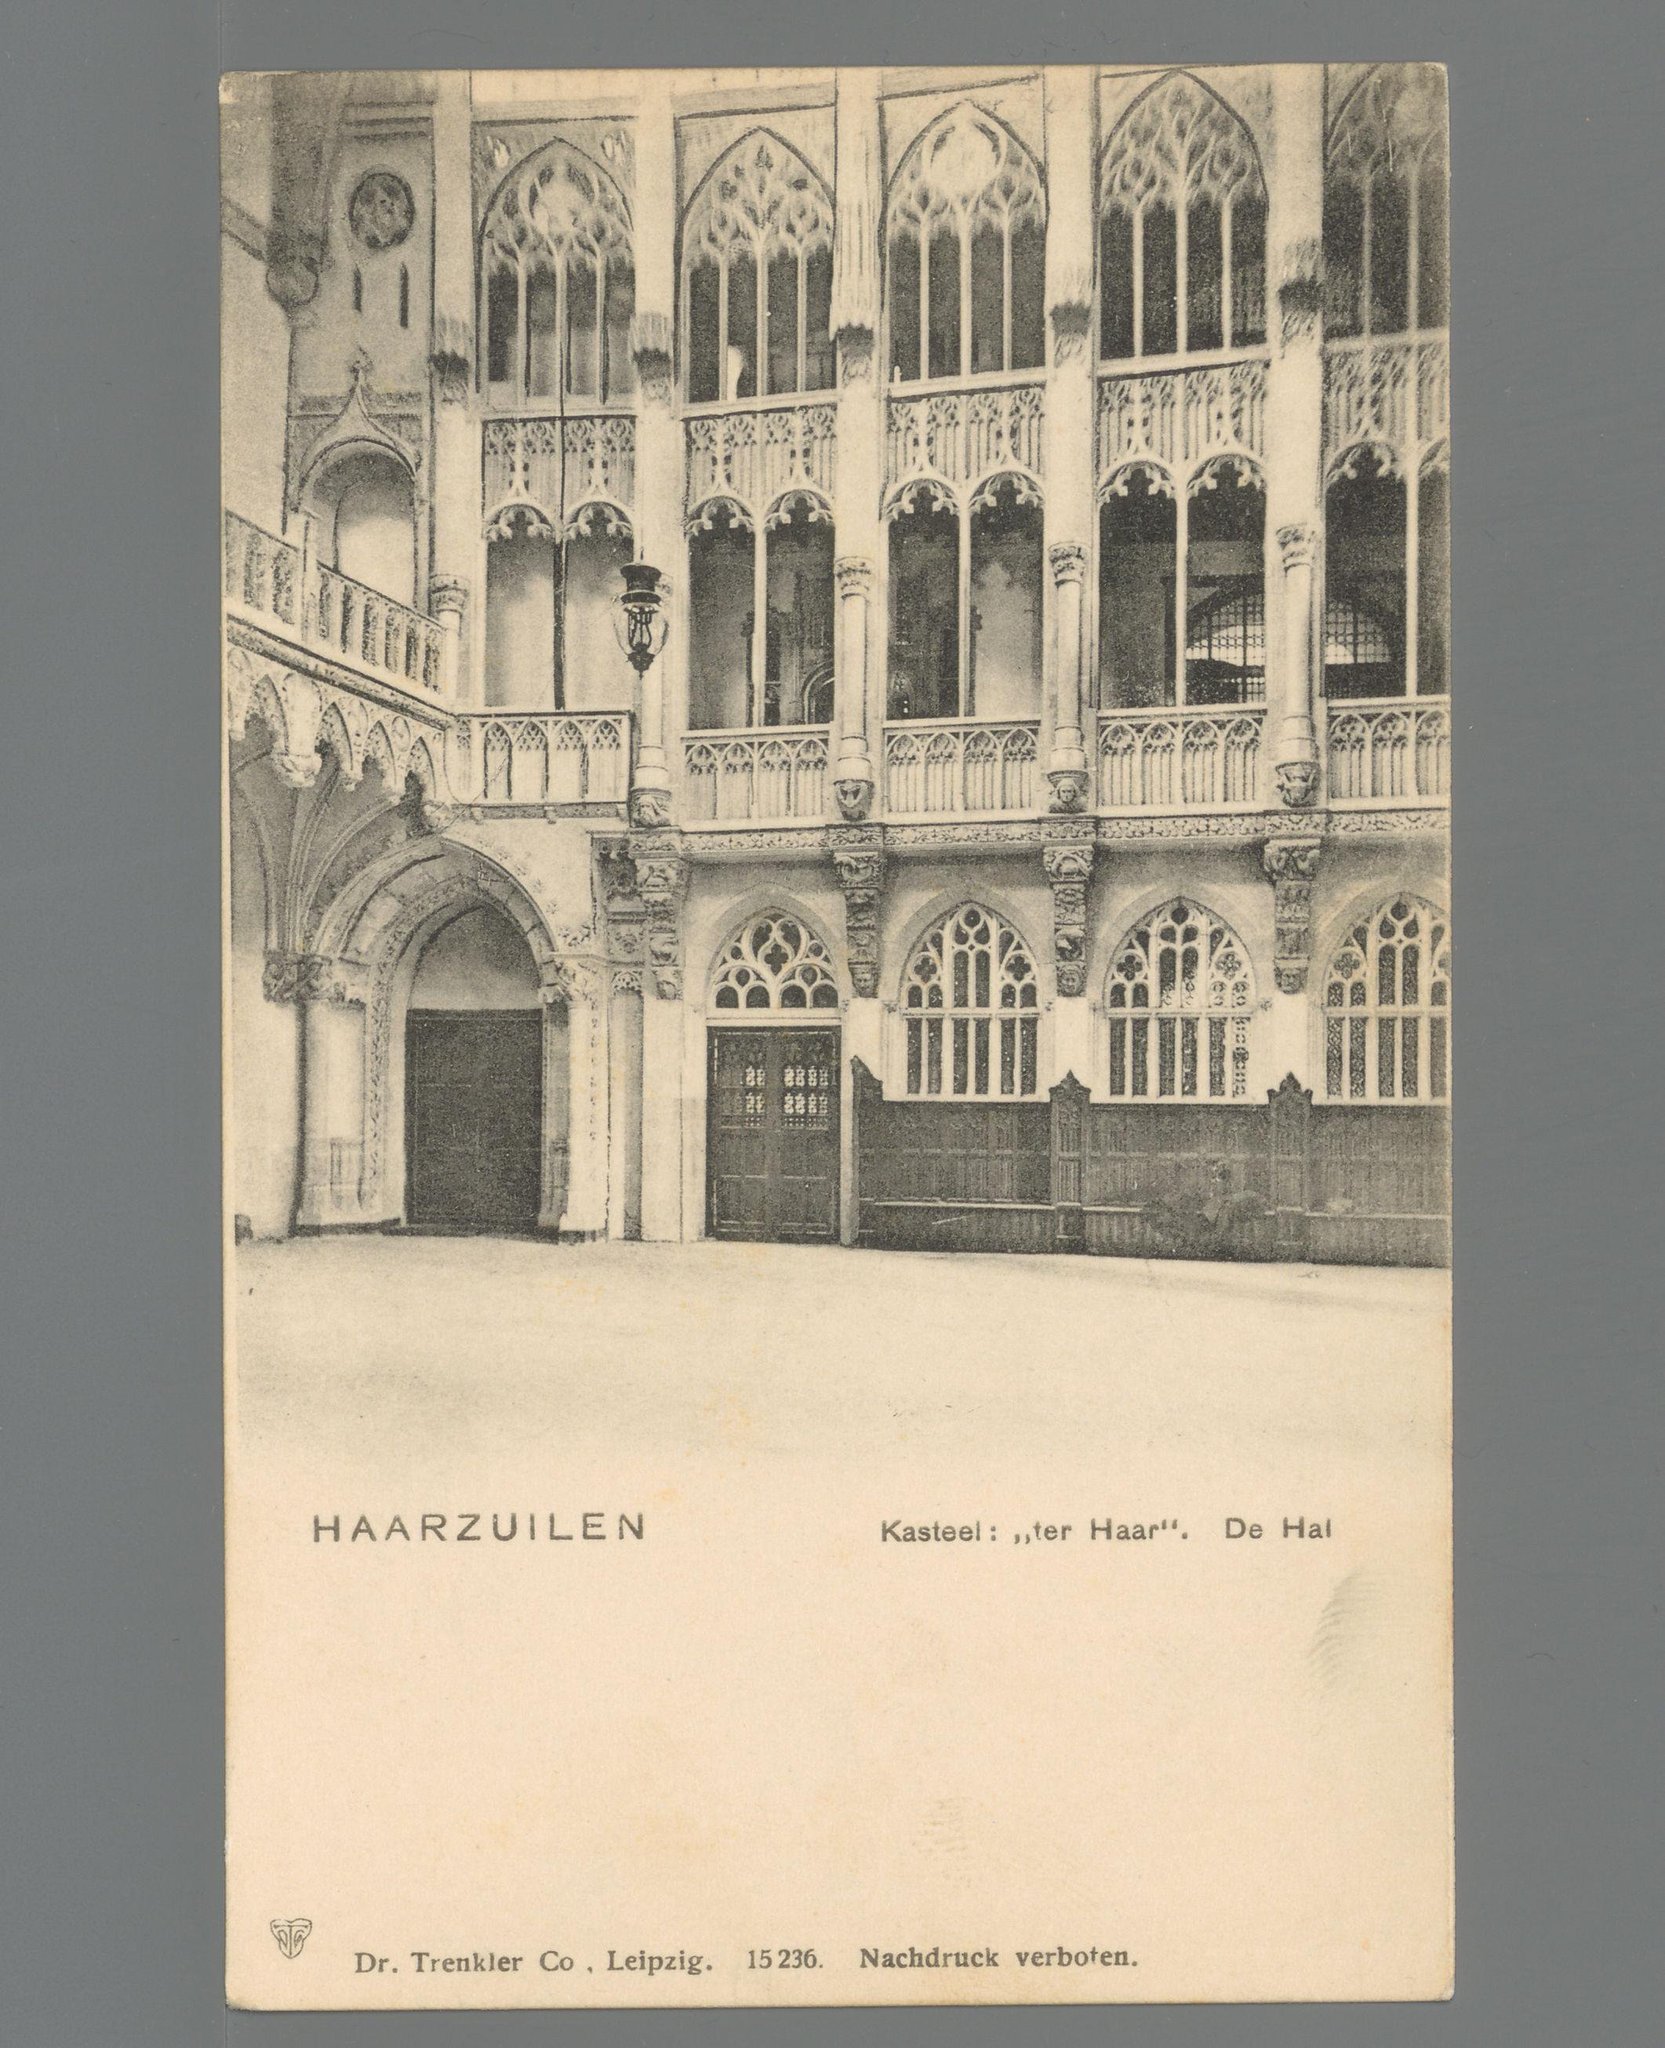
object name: photomechanical print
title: Haarzuilen. Kasteel: "ter Haar". De hal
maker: Anonymous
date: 1897-1905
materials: cardboard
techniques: photograph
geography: leipzig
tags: column, pillar ~ architecture, castle, vestibule, hall